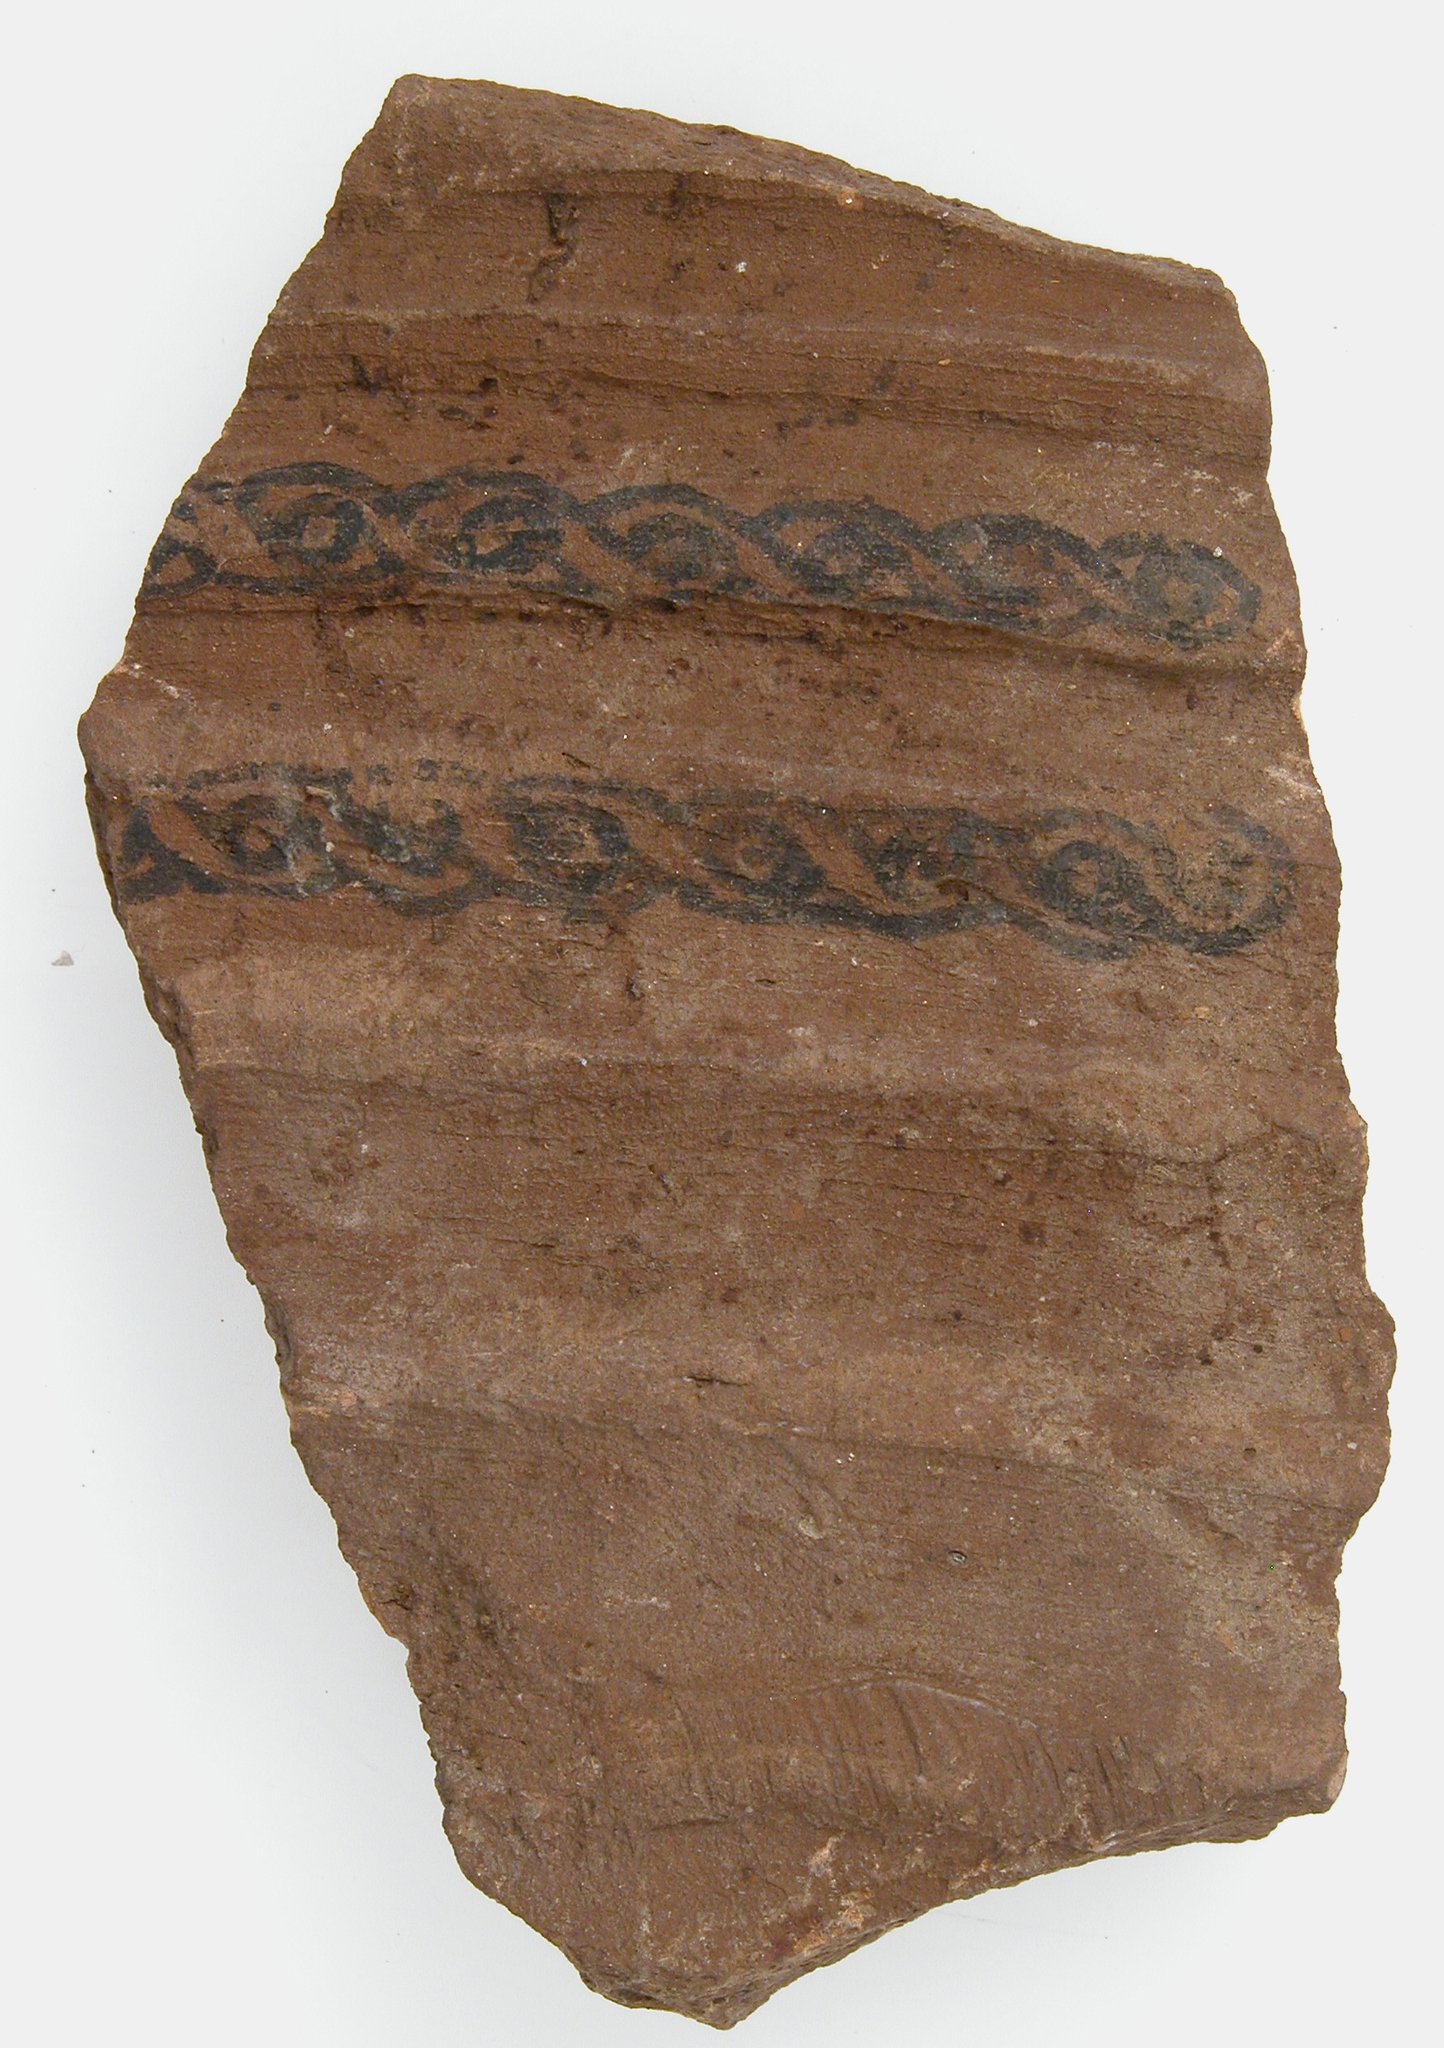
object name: ostrakon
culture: coptic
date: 601-700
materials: ink, pottery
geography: egypt